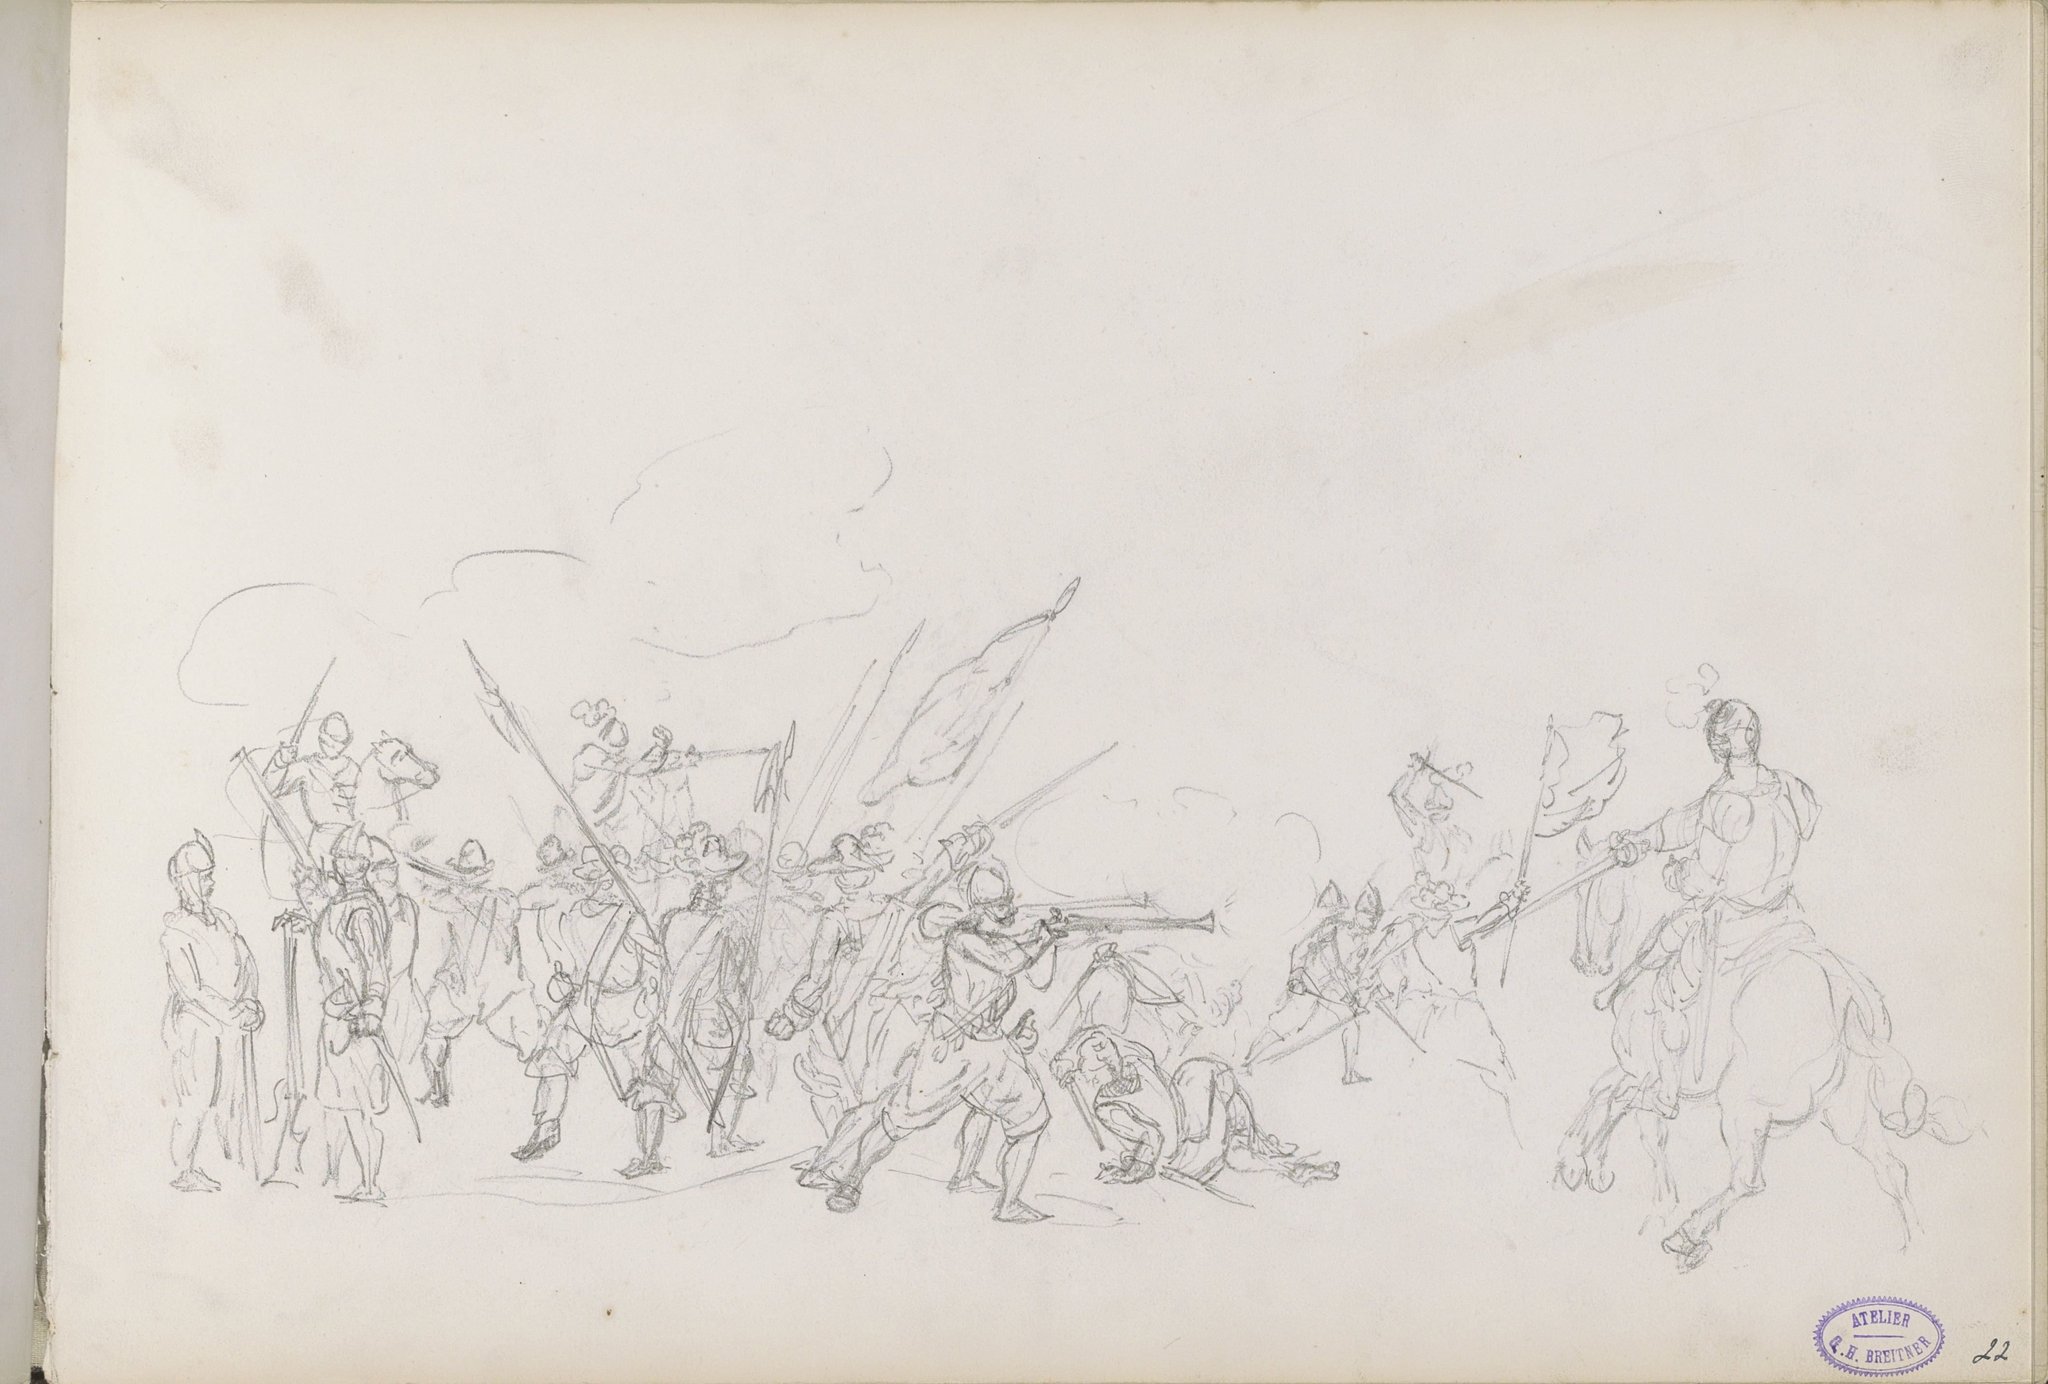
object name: sketchbook leaf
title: Strijdende soldaten met verschillende wapens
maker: george hendrik breitner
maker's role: draughtsman, painter, print maker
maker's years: 1857-1923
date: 1873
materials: paper, pencil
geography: rotterdam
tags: division of armed forces (+ during the battle), division of armed forces (+ cavalry, horsemen), division of armed forces (+ infantry)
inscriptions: workshop stamp: Lugt 291d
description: Blad 22 recto uit een schetsboek met 25 bladen.